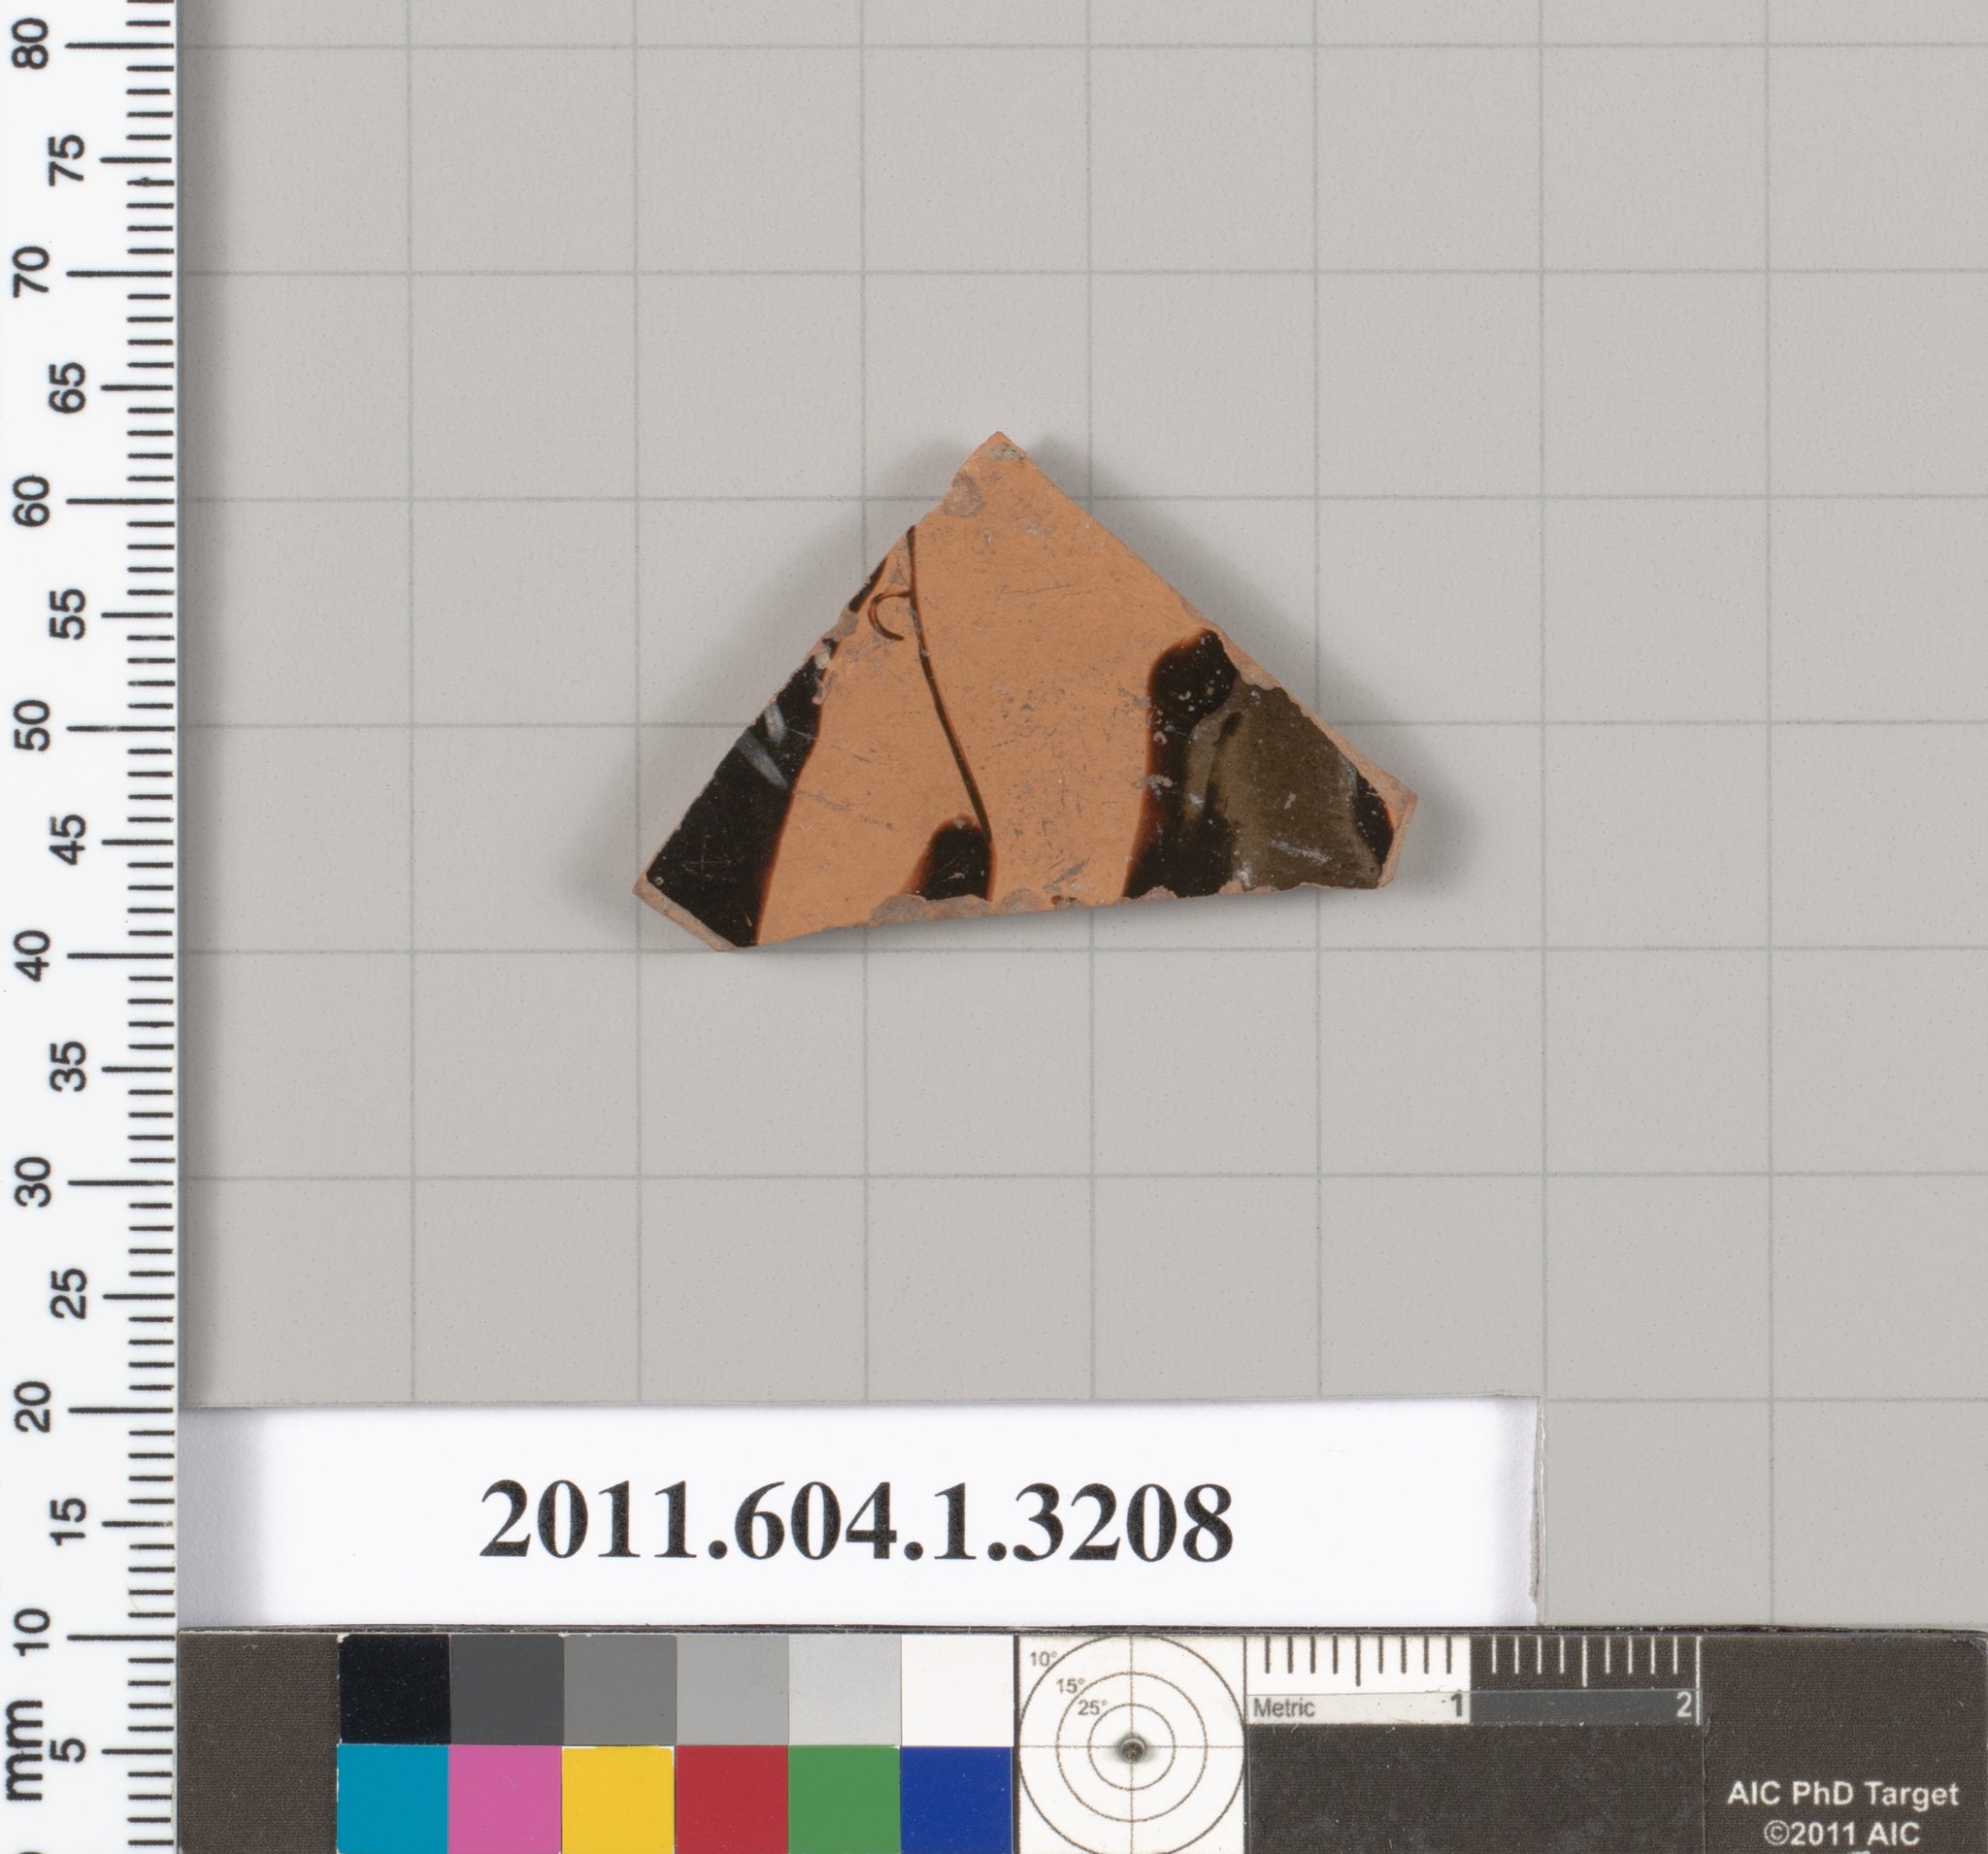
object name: kylix fragment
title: Terracotta fragment of a kylix (drinking cup)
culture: greek, attic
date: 467-435 BCE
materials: terracotta